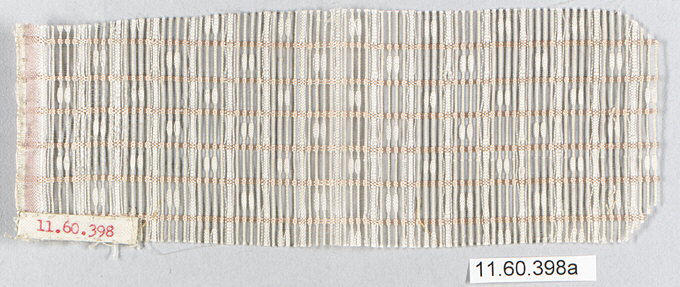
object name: fragment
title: Fragments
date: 1801-1900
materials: silk